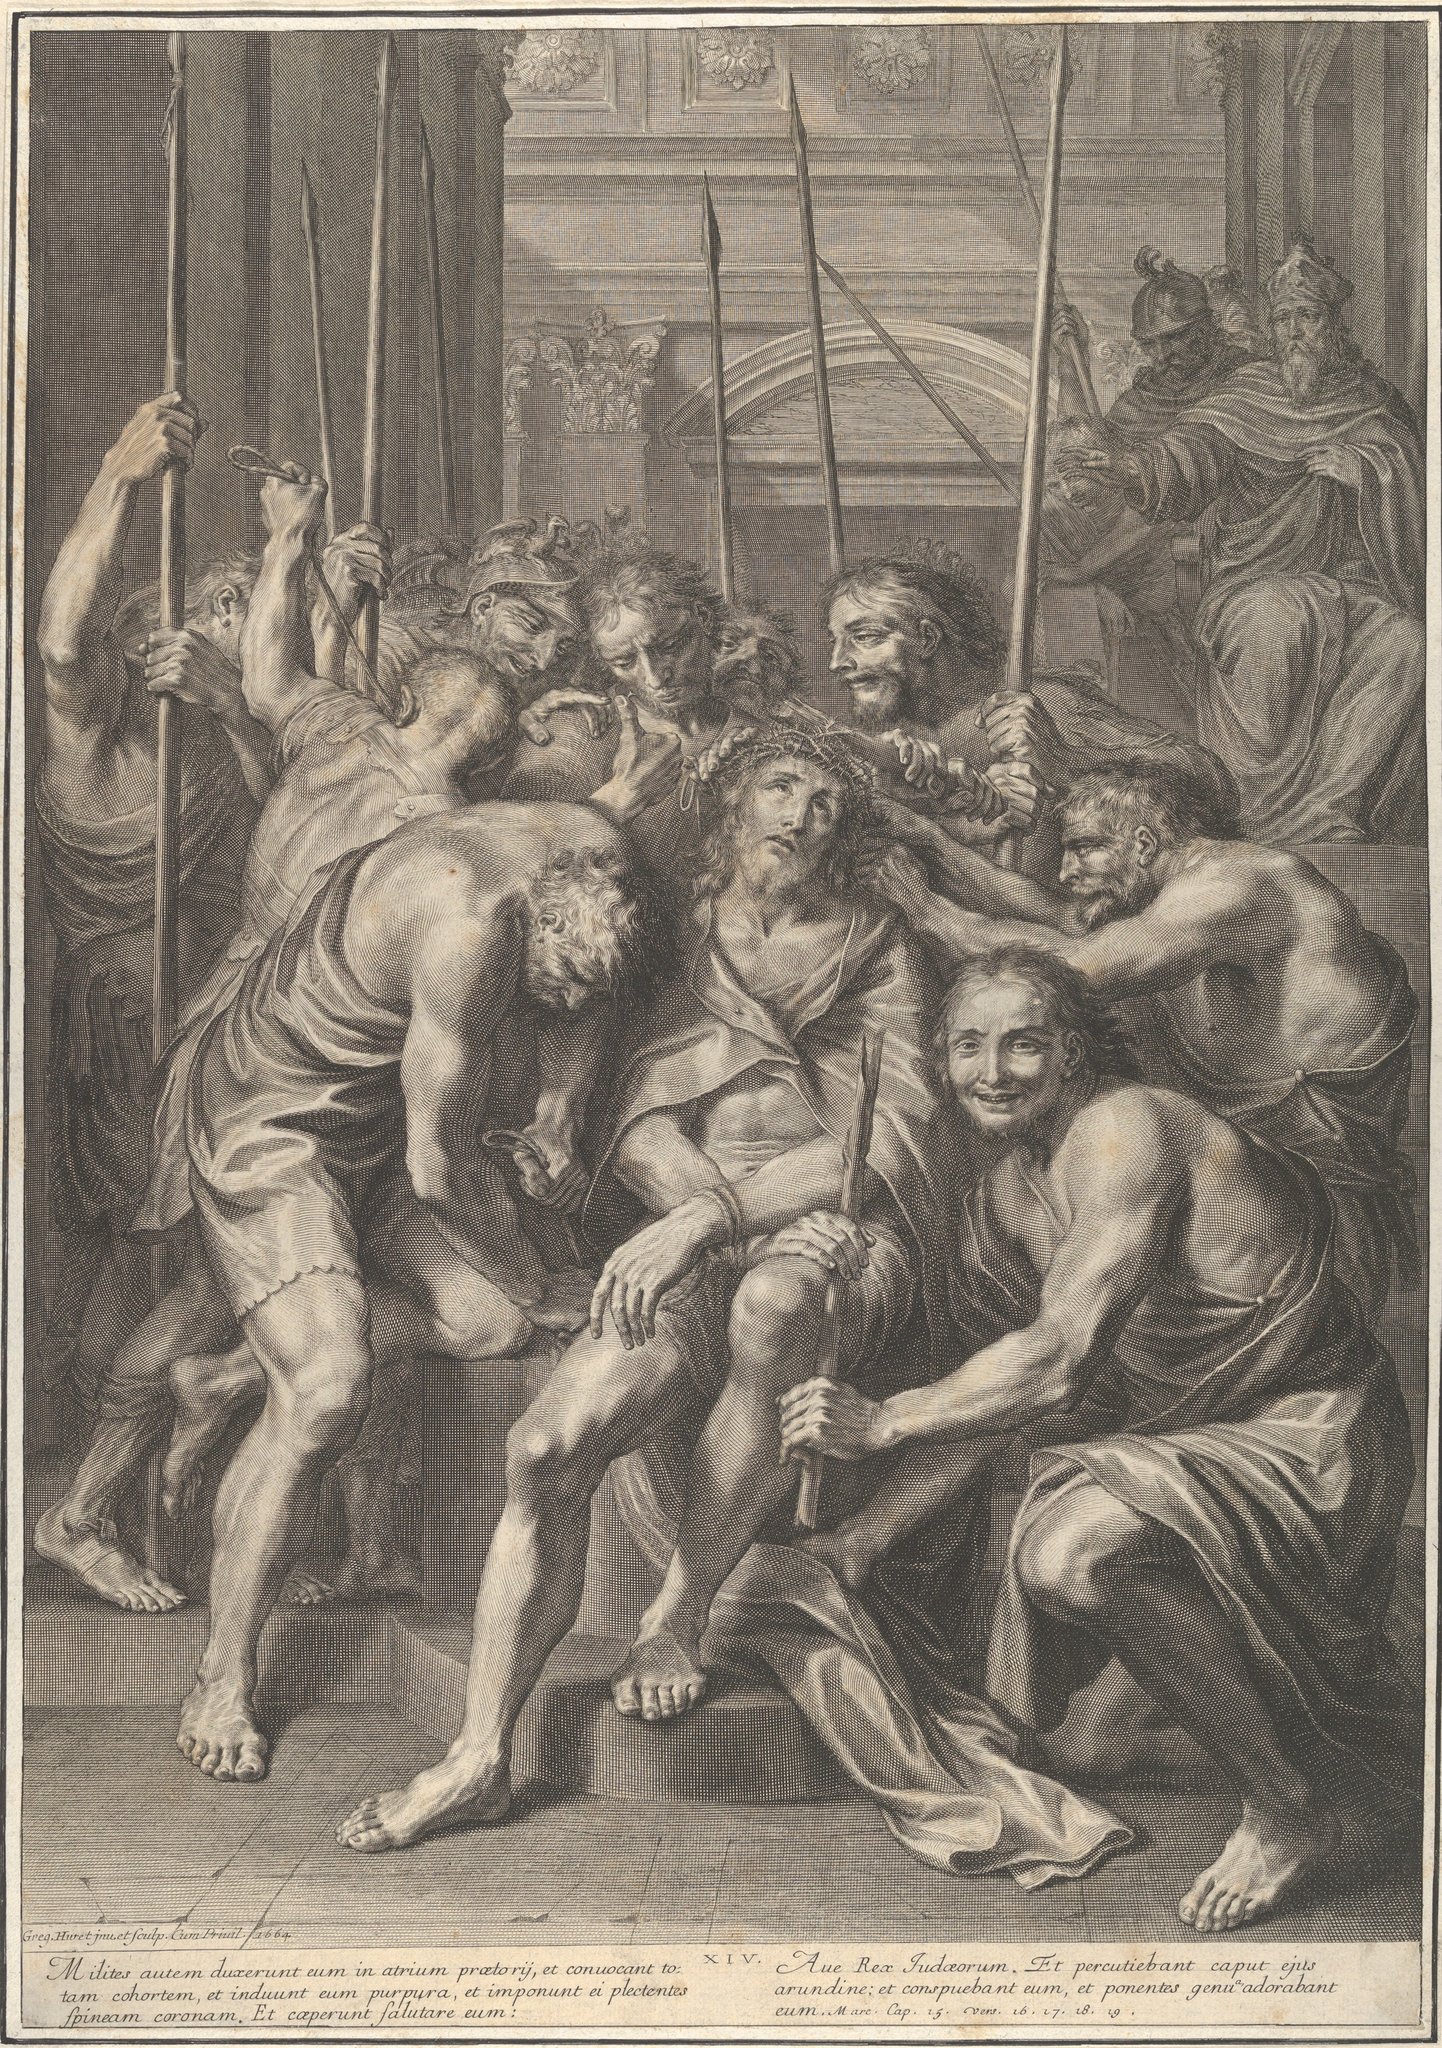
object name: print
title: Christ Crowned with Thornes, from The Passion of Christ, plate 14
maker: grégoire huret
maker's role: artist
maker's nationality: french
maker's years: 1606-1670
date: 1664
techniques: engraving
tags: men,christ